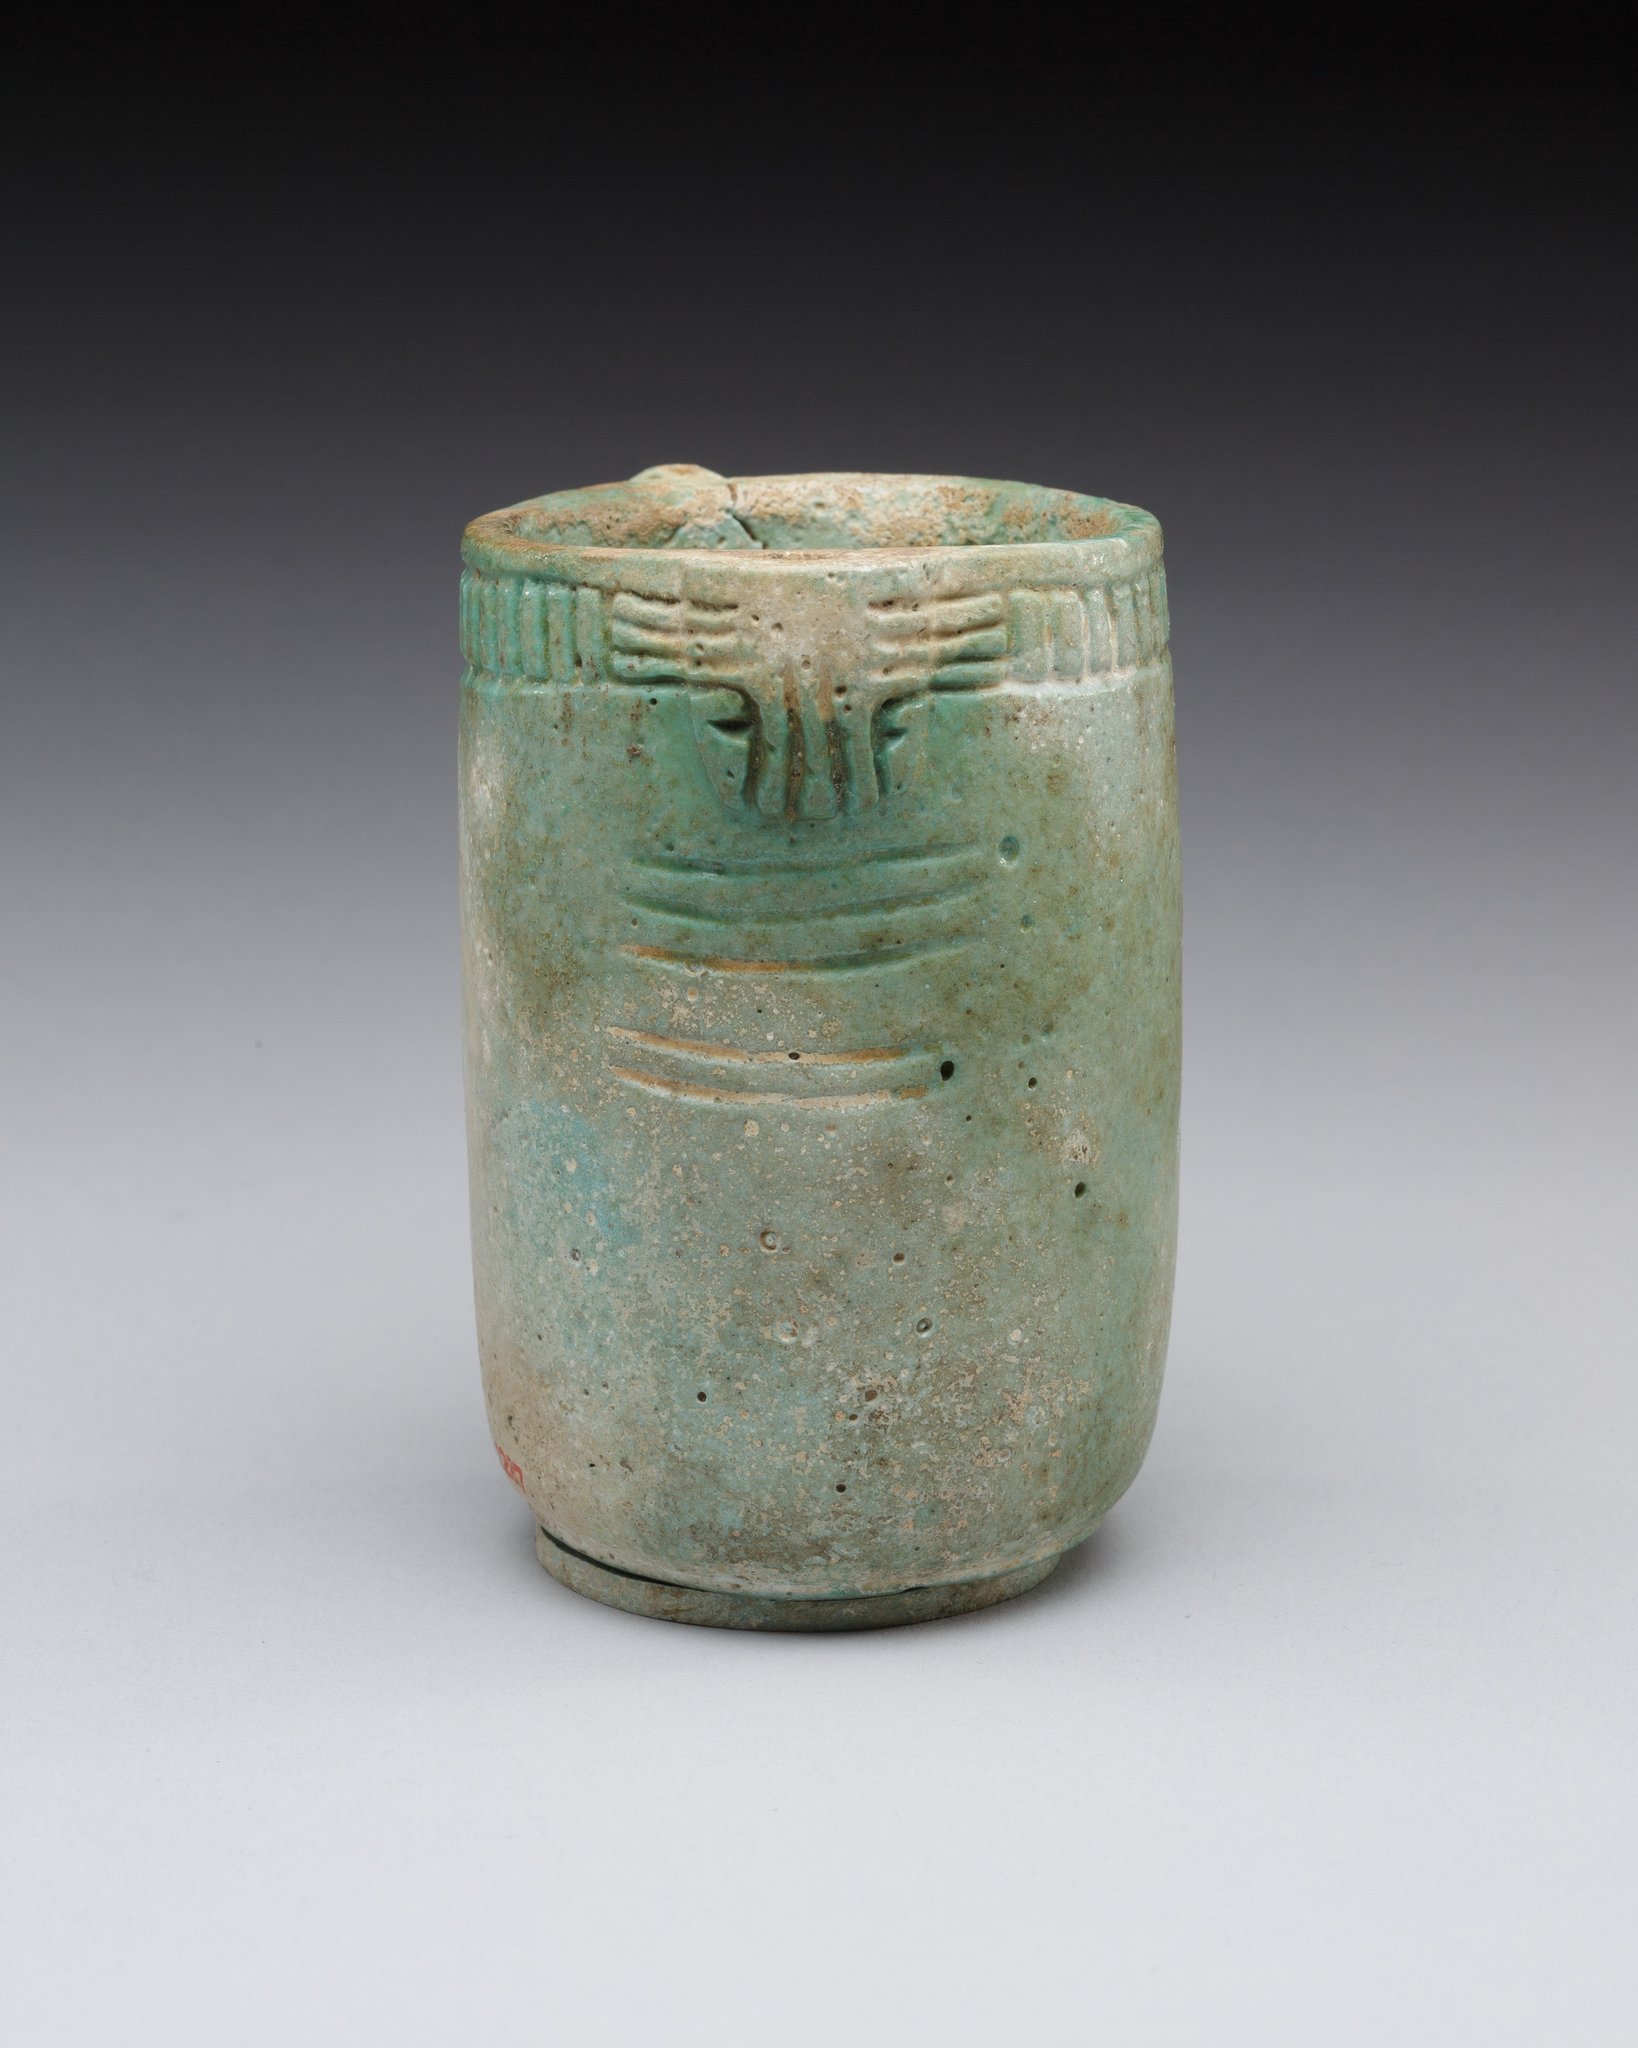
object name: jar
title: Jar with decorated rim, swivel, and knob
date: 664-630 BCE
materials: faience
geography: egypt